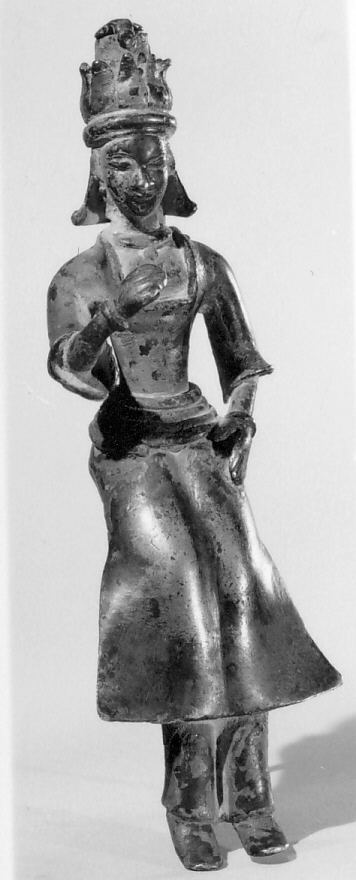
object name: figure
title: Seated Figure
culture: afghan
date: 901-1000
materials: bronze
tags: human figures,gandharan